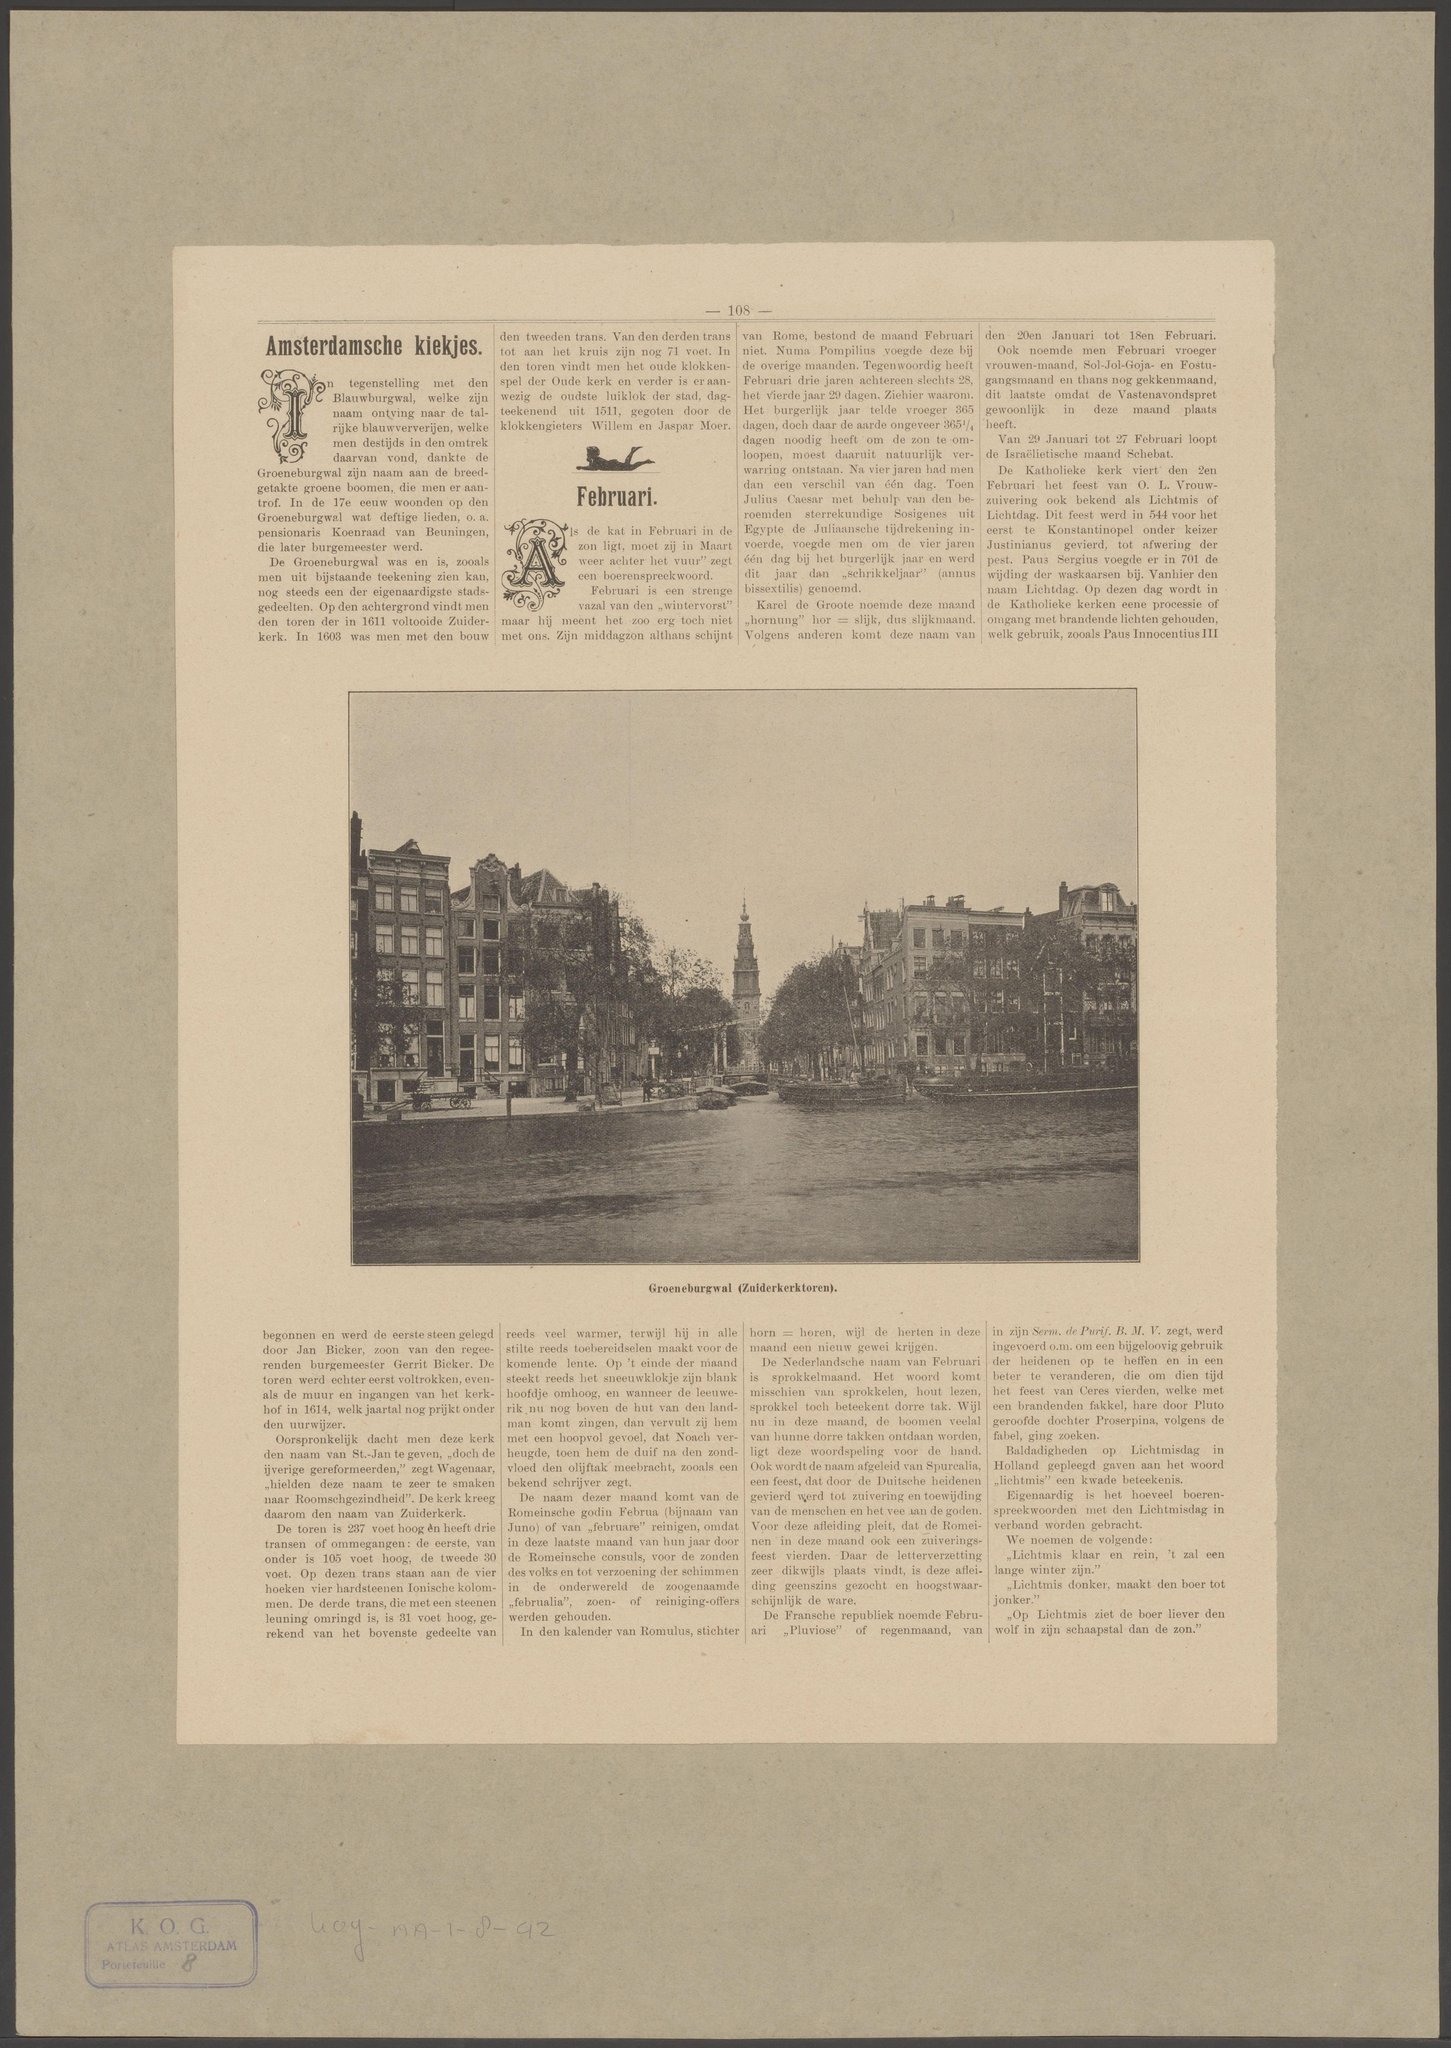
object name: page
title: Gezicht op de Groenburgwal en de Zuiderkerkstoren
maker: Anonymous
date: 1882-1950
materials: paper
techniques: letterpress printing, line block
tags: tower, clock tower ~ monumental adornment, city-view in general; 'veduta', canal, the usual house or row of houses, bridge in city across river, canal, etc.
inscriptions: collector's mark: ‘8’ Lugt 1641b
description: Onderwerpsrubriek binnen de Atlas Amsterdam: Galerij Paleis voor Volksvlijt, Gebed zonder end, Geldersche Kade, Gravenstraat, Grimburgwal, Grimnessesluis, Groeneburgwal.